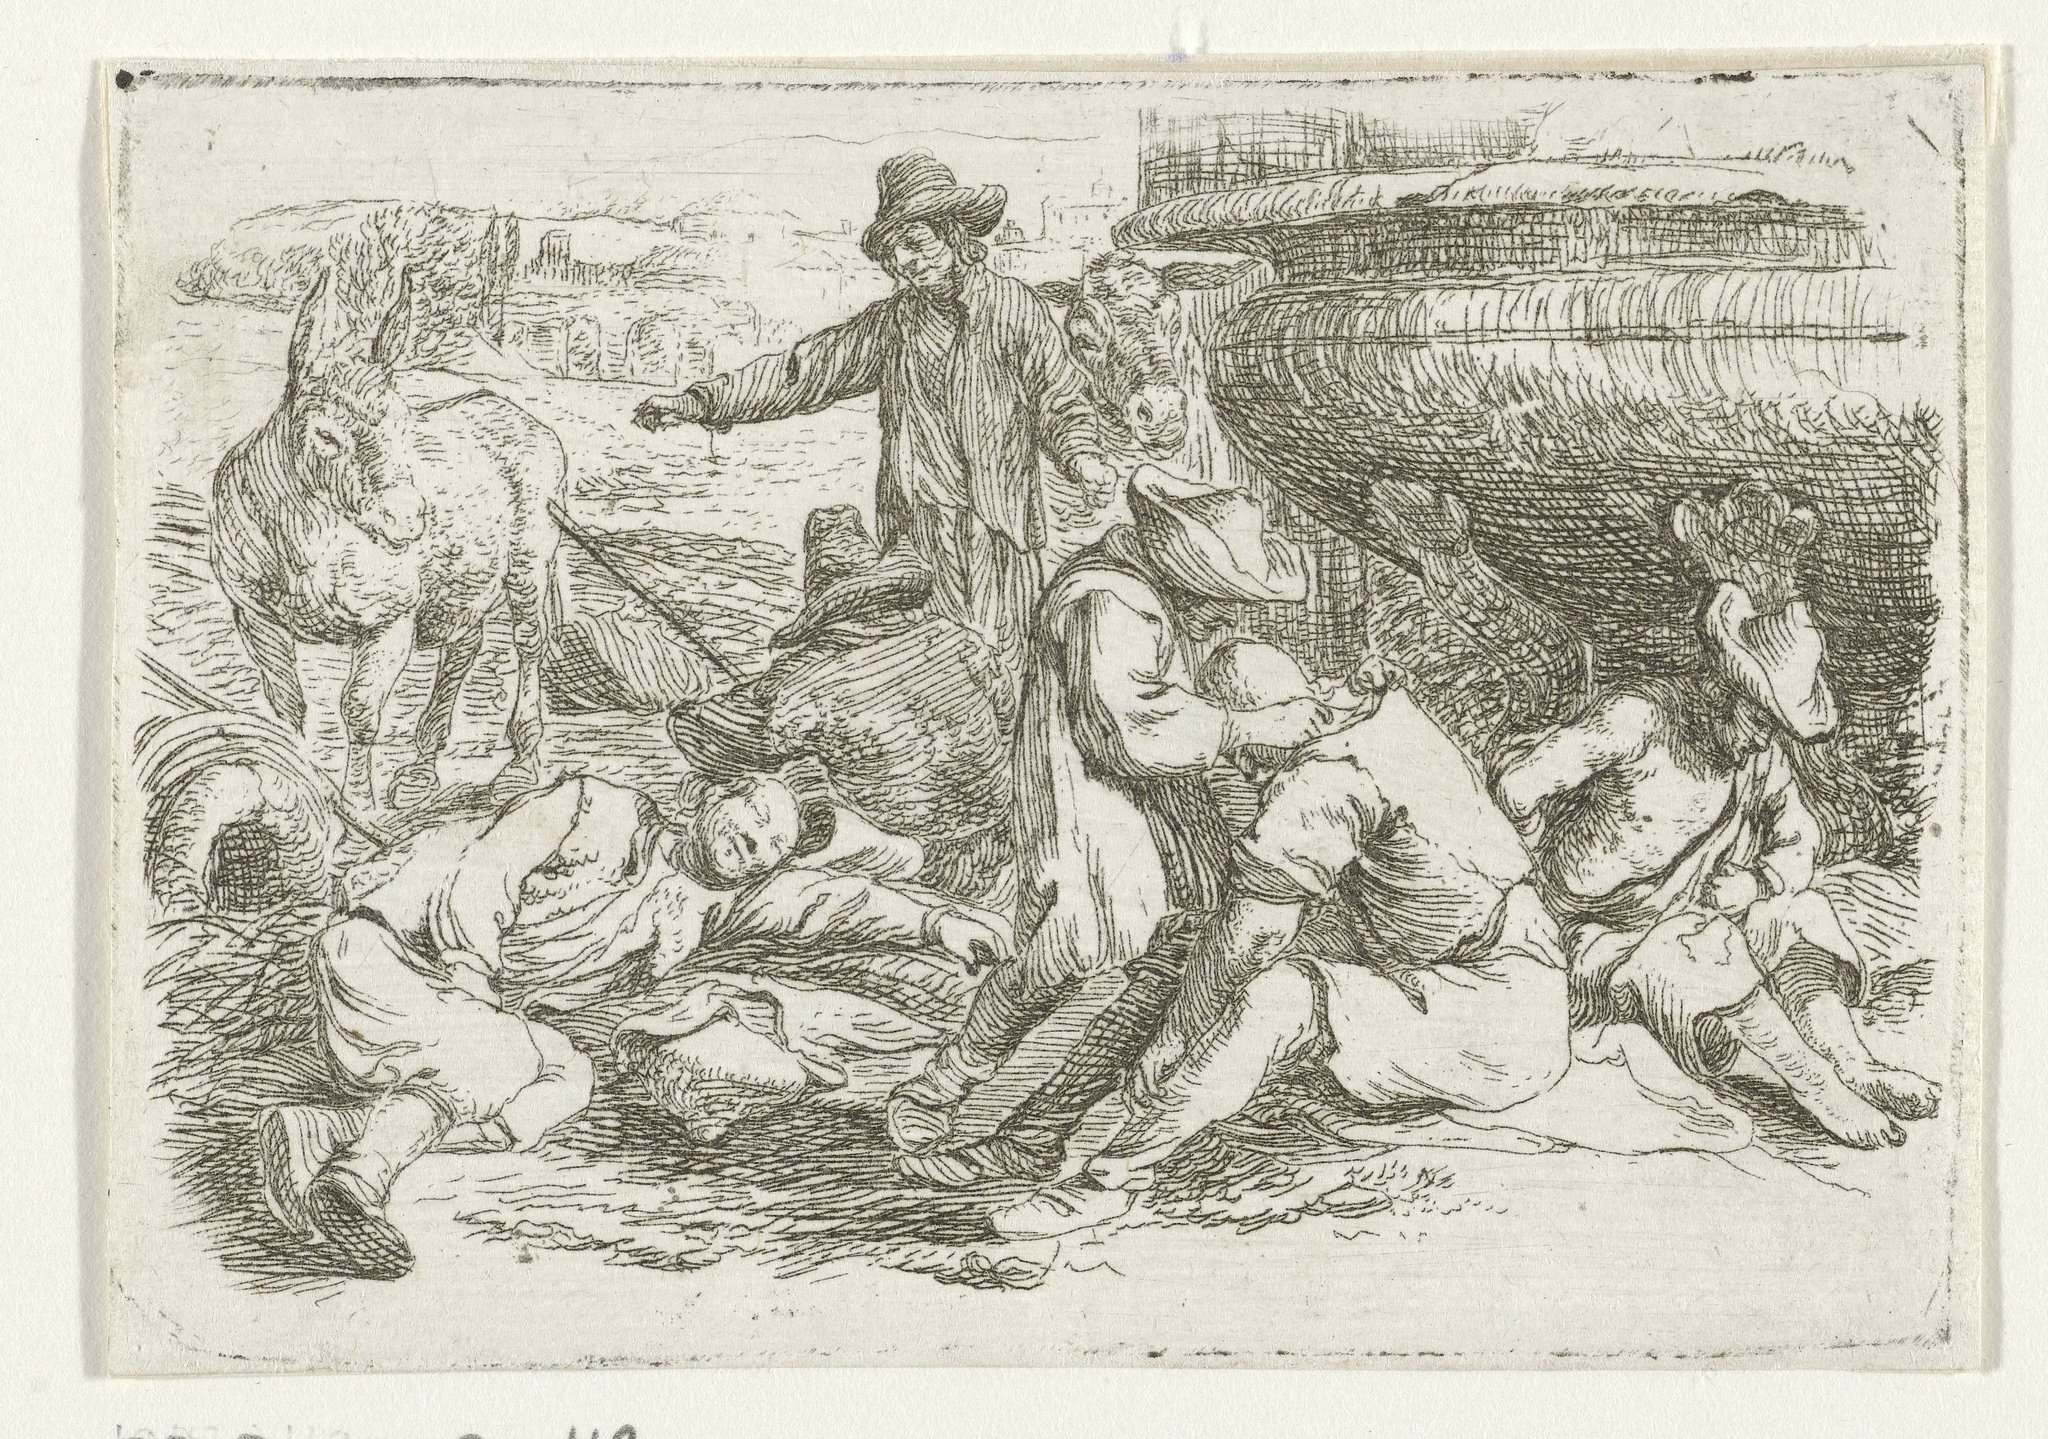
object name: print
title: Zes bedelaars bij een fontein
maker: jan van ossenbeeck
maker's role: print maker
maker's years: 1623-1674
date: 1647-1674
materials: paper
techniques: etching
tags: beggar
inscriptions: collector's mark: Lugt 2228, collector's mark: Lugt 2161